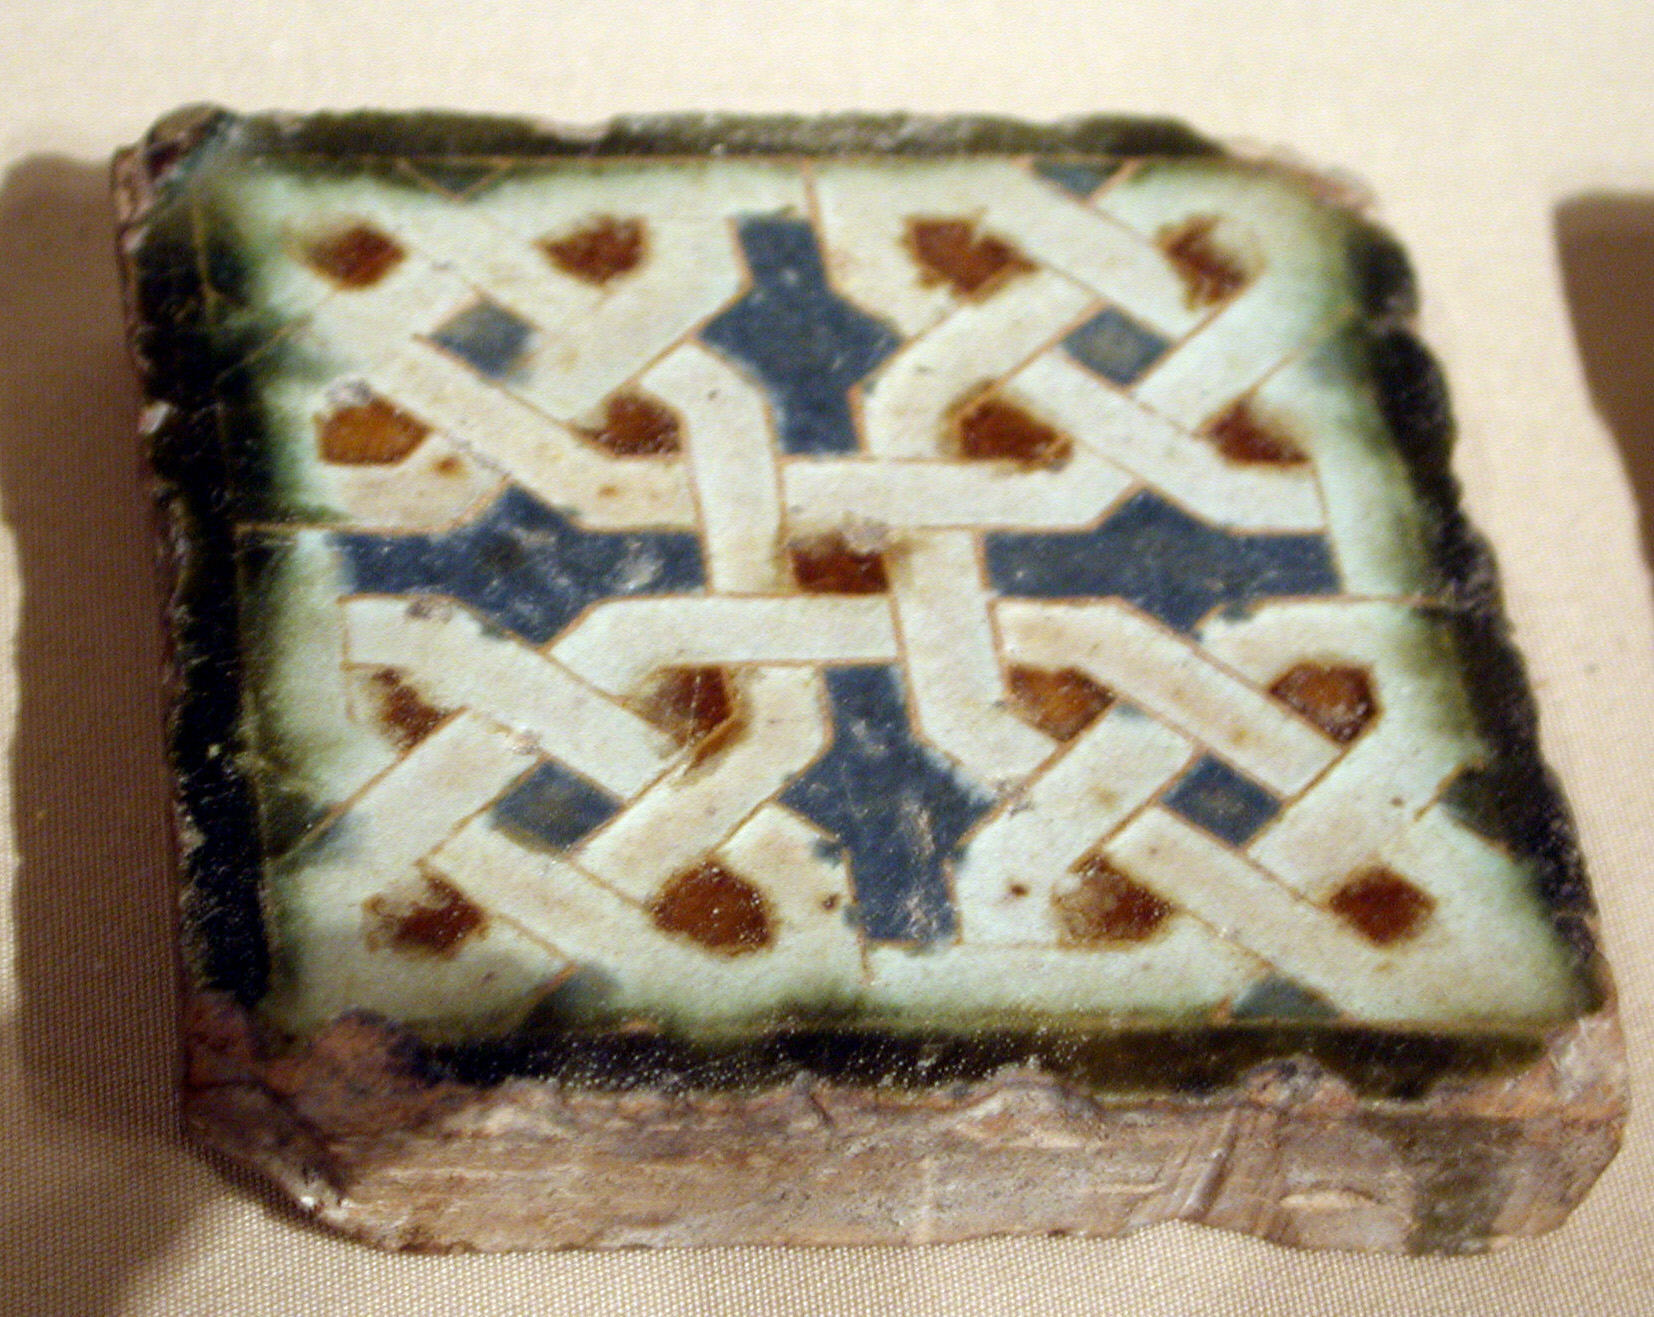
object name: pavement tile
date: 1501-1600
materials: earthenware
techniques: glazing